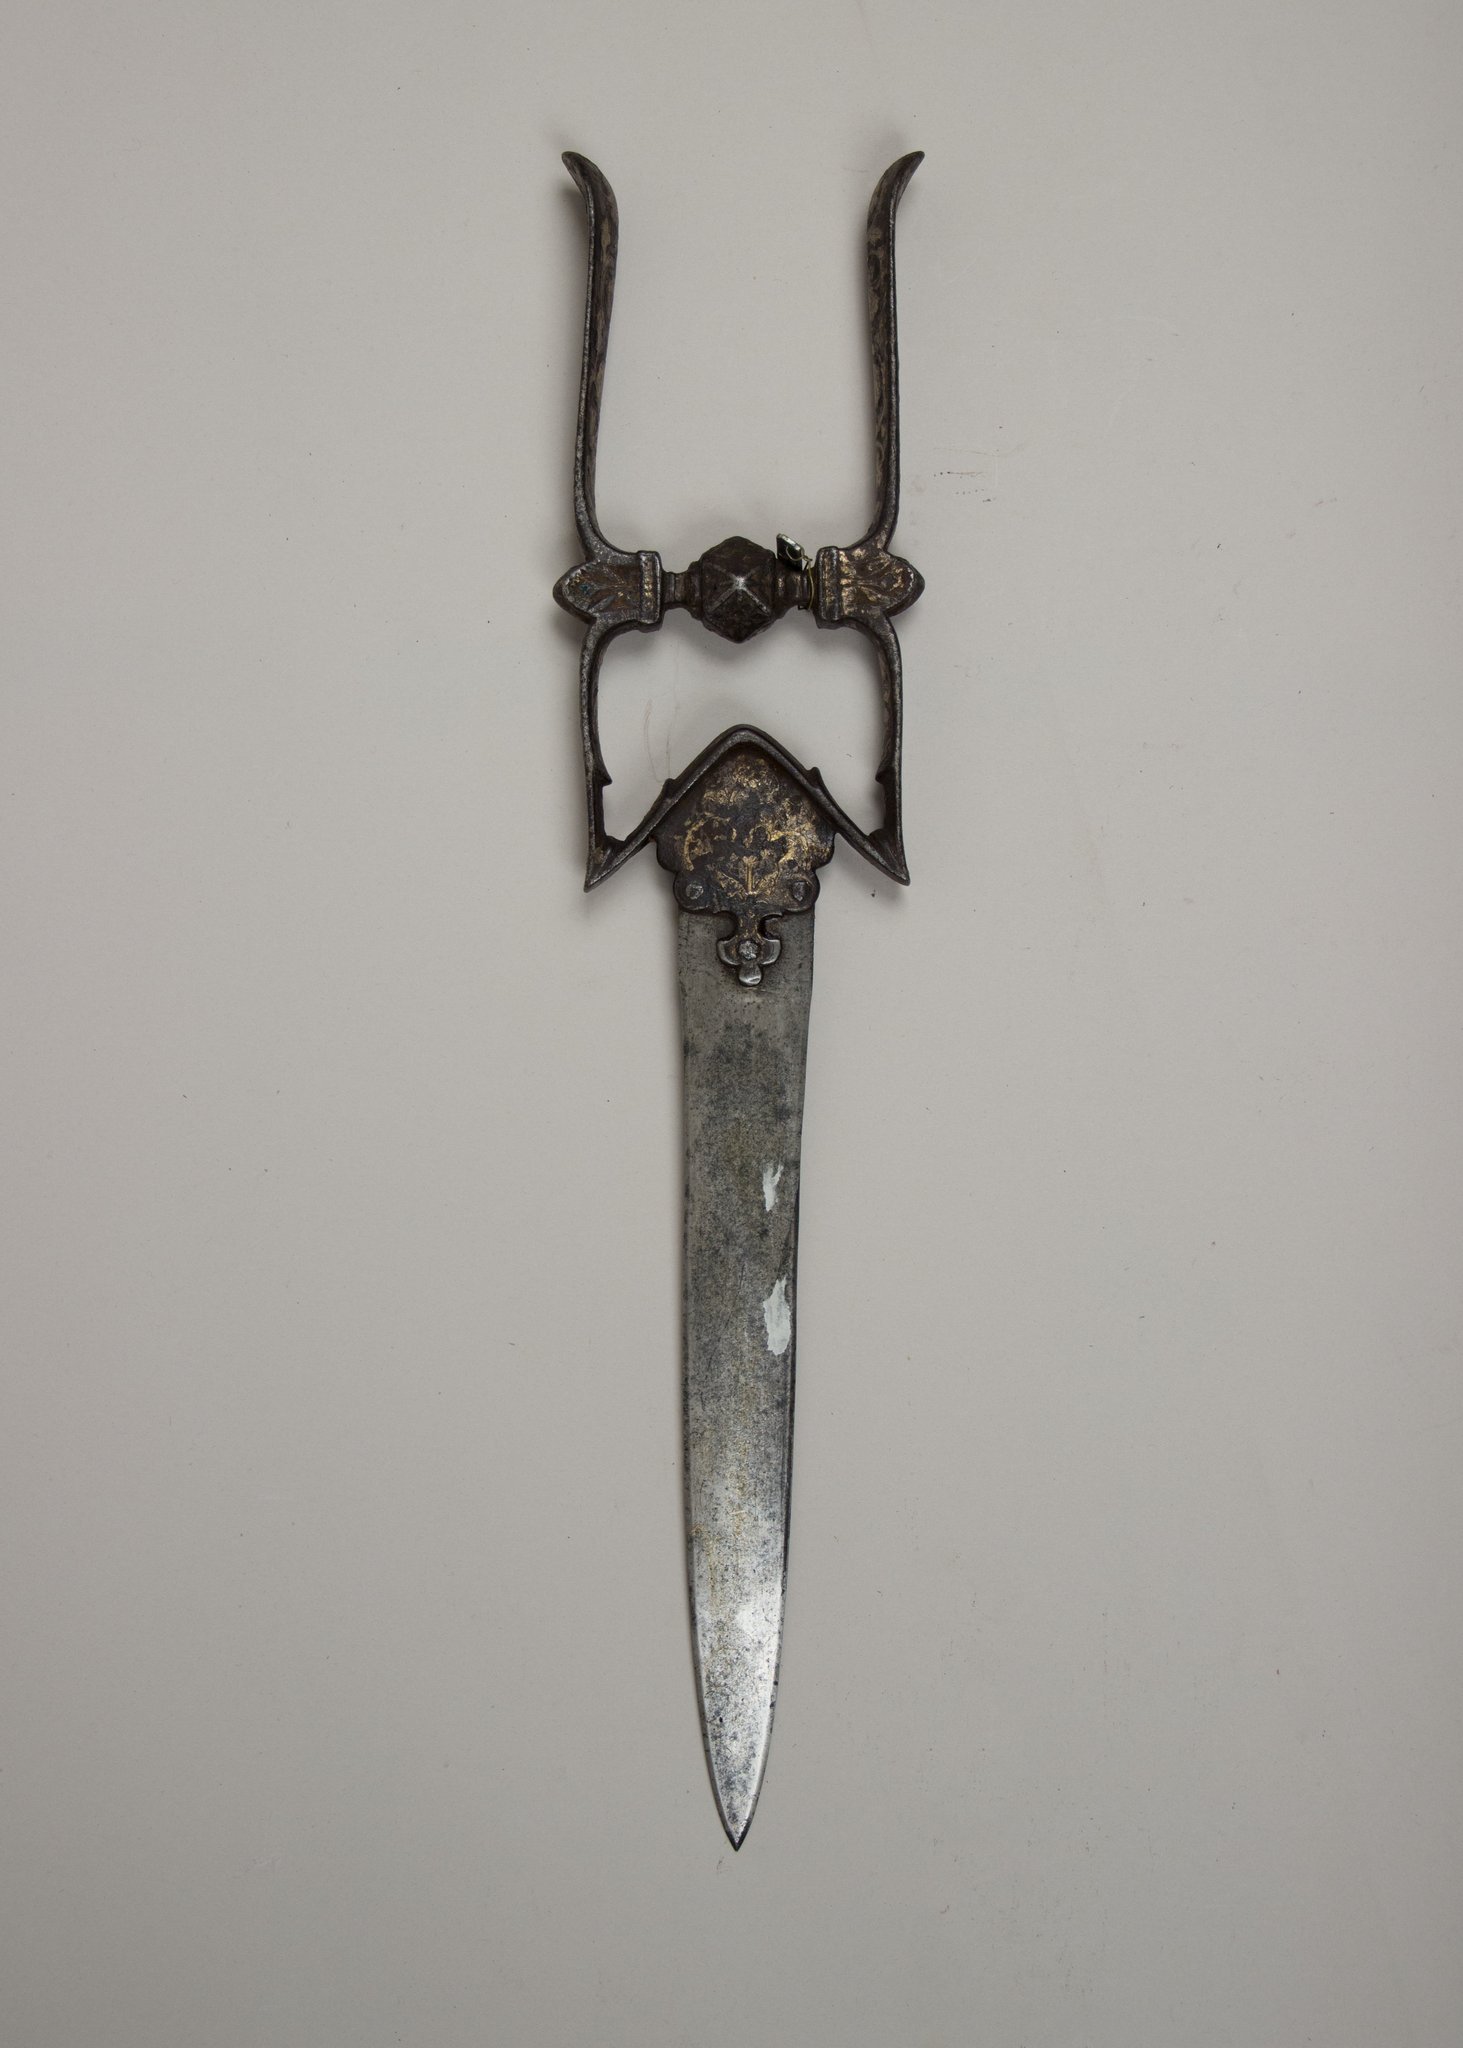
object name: dagger katar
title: Dagger (Katar)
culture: european or indian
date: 1801-1900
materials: gold, silver, steel